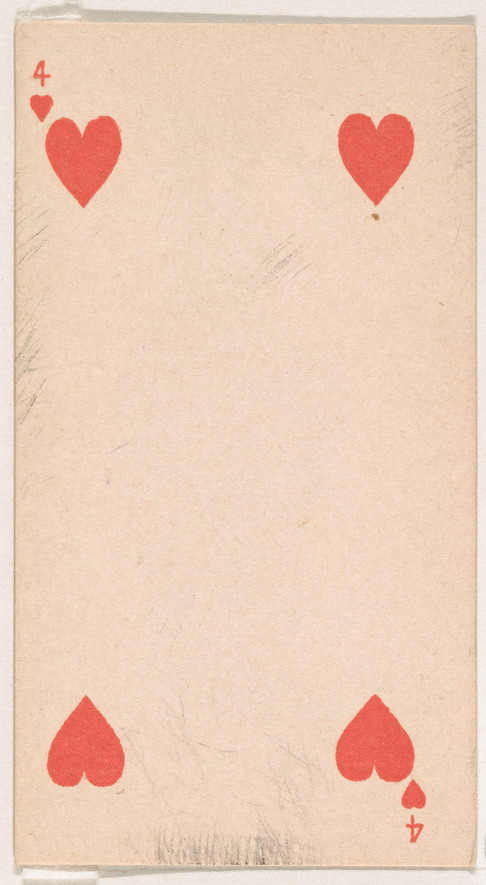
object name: print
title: Four of Hearts, from the Transparent Playing Cards series (N220) issued by Kinney Bros.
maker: kinney brothers tobacco company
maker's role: publisher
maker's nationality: american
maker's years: 1869-2011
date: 1888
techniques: color lithograph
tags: playing cards